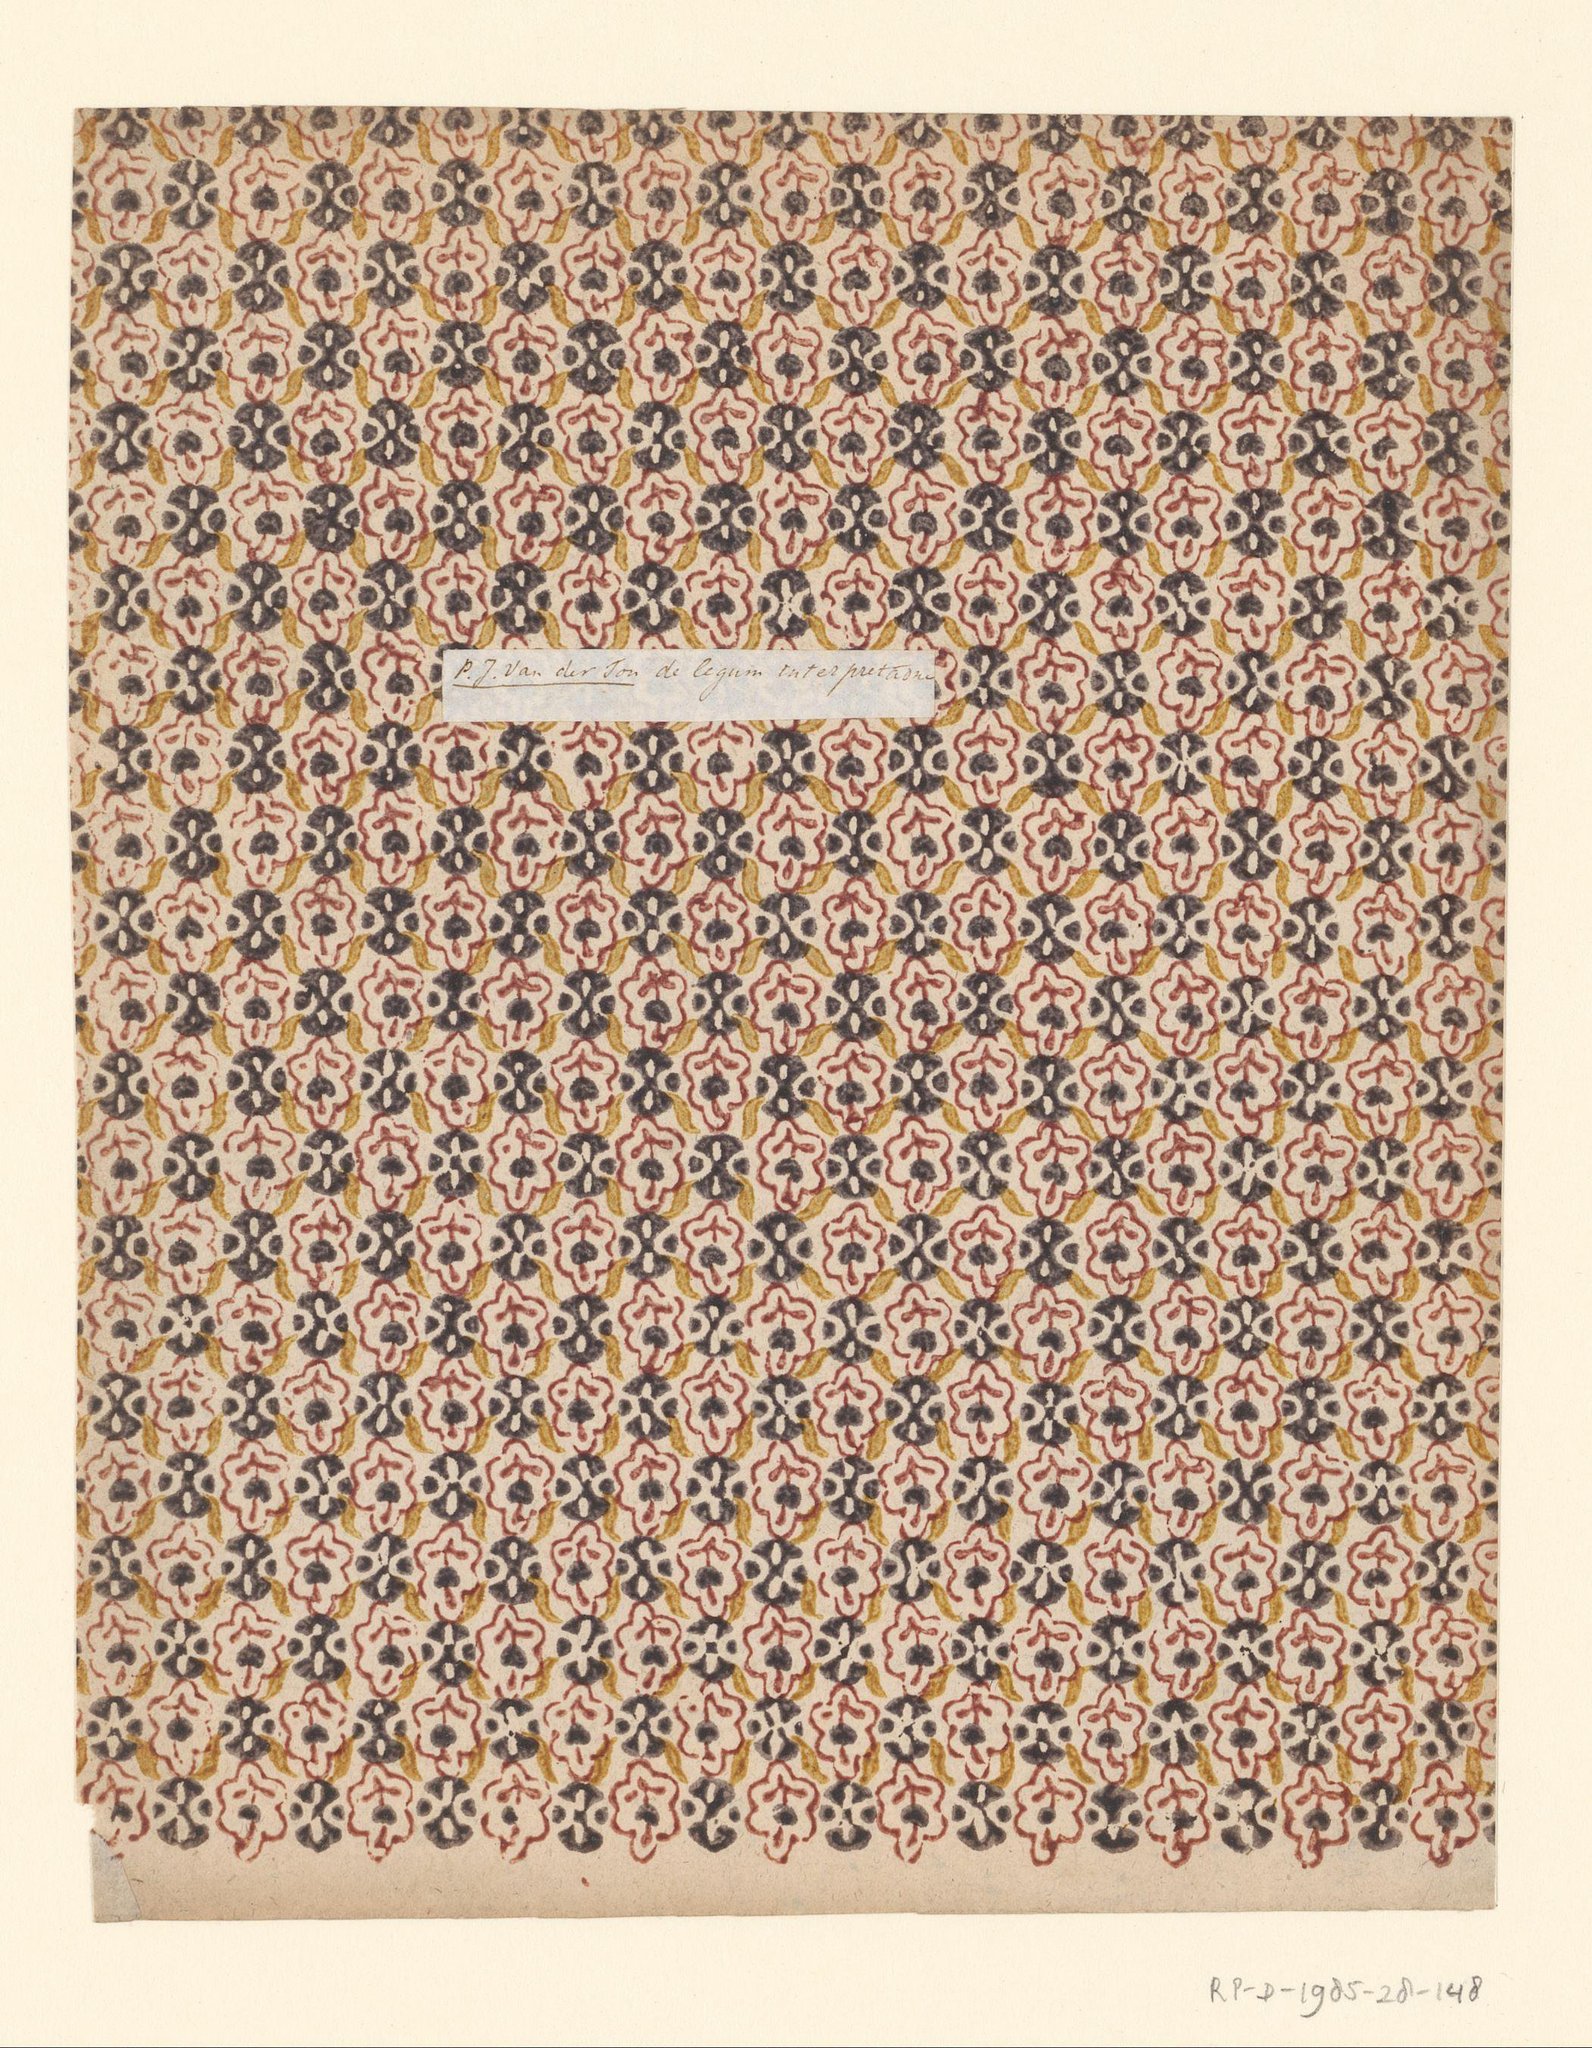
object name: wrapper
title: Blad met alternerend strooipatroon van bloemmotieven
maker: Anonymous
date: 1750-1900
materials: paper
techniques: printing block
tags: ornament derived from plant forms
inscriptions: collector's mark: Lugt 2760, collector's mark: Lugt 2228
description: Blad met alternerend strooipatroon van bloemmotieven. Met etiket met opschrift: 'P.J. van der Ton ... interpretadre'. Helft van een omslag.